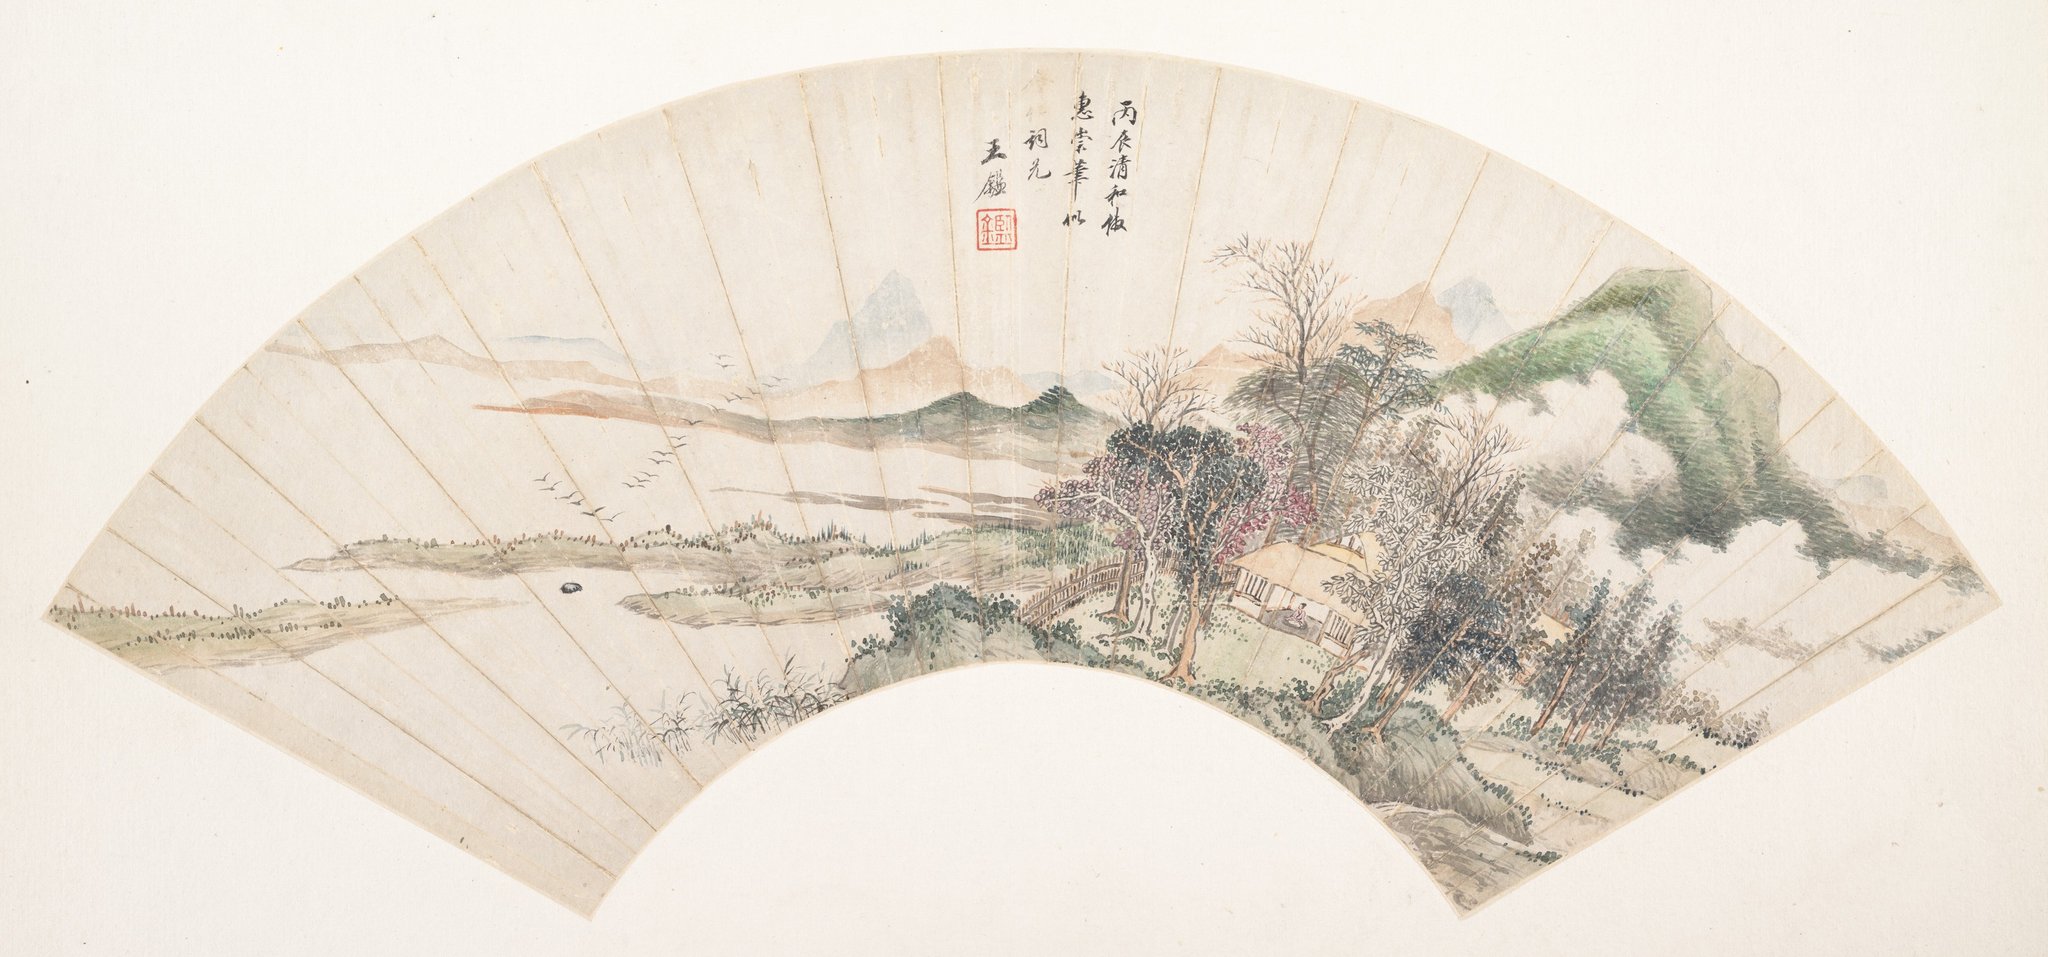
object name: folding fan mounted a an album leaf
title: Landscape in the Style of Huichong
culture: chinese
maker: unidentified artist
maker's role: artist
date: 1701-1800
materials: ink, paper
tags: landscapes